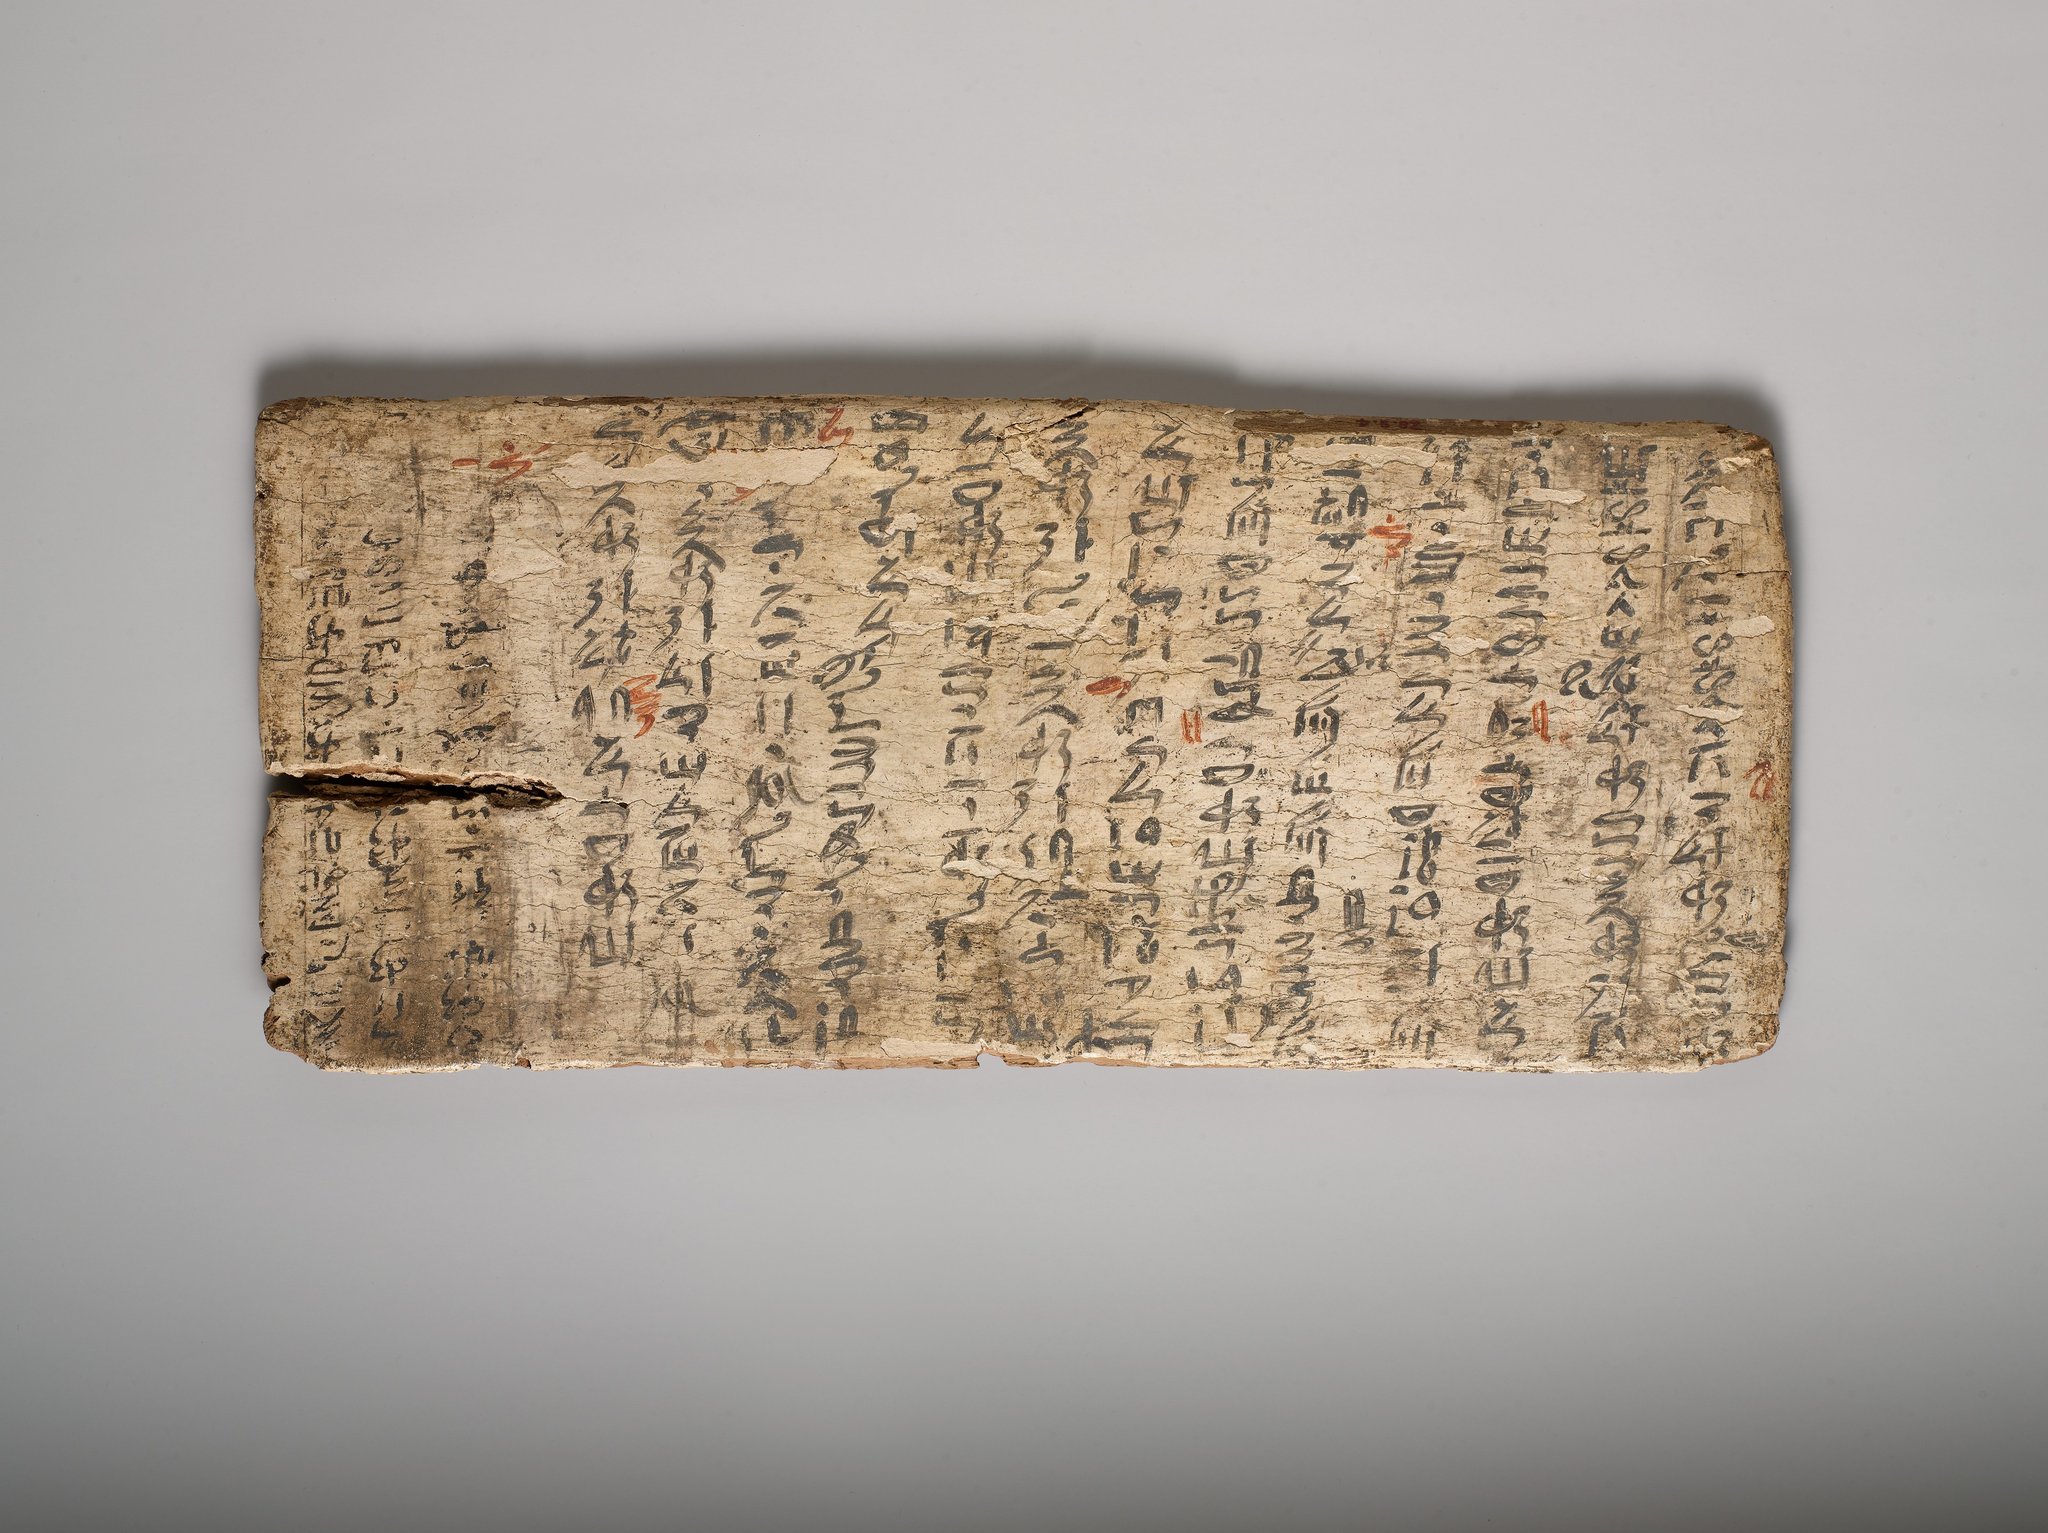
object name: writing board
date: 1981-1802 BCE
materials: gesso, paint, wood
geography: upper egypt, thebes or northern upper egypt